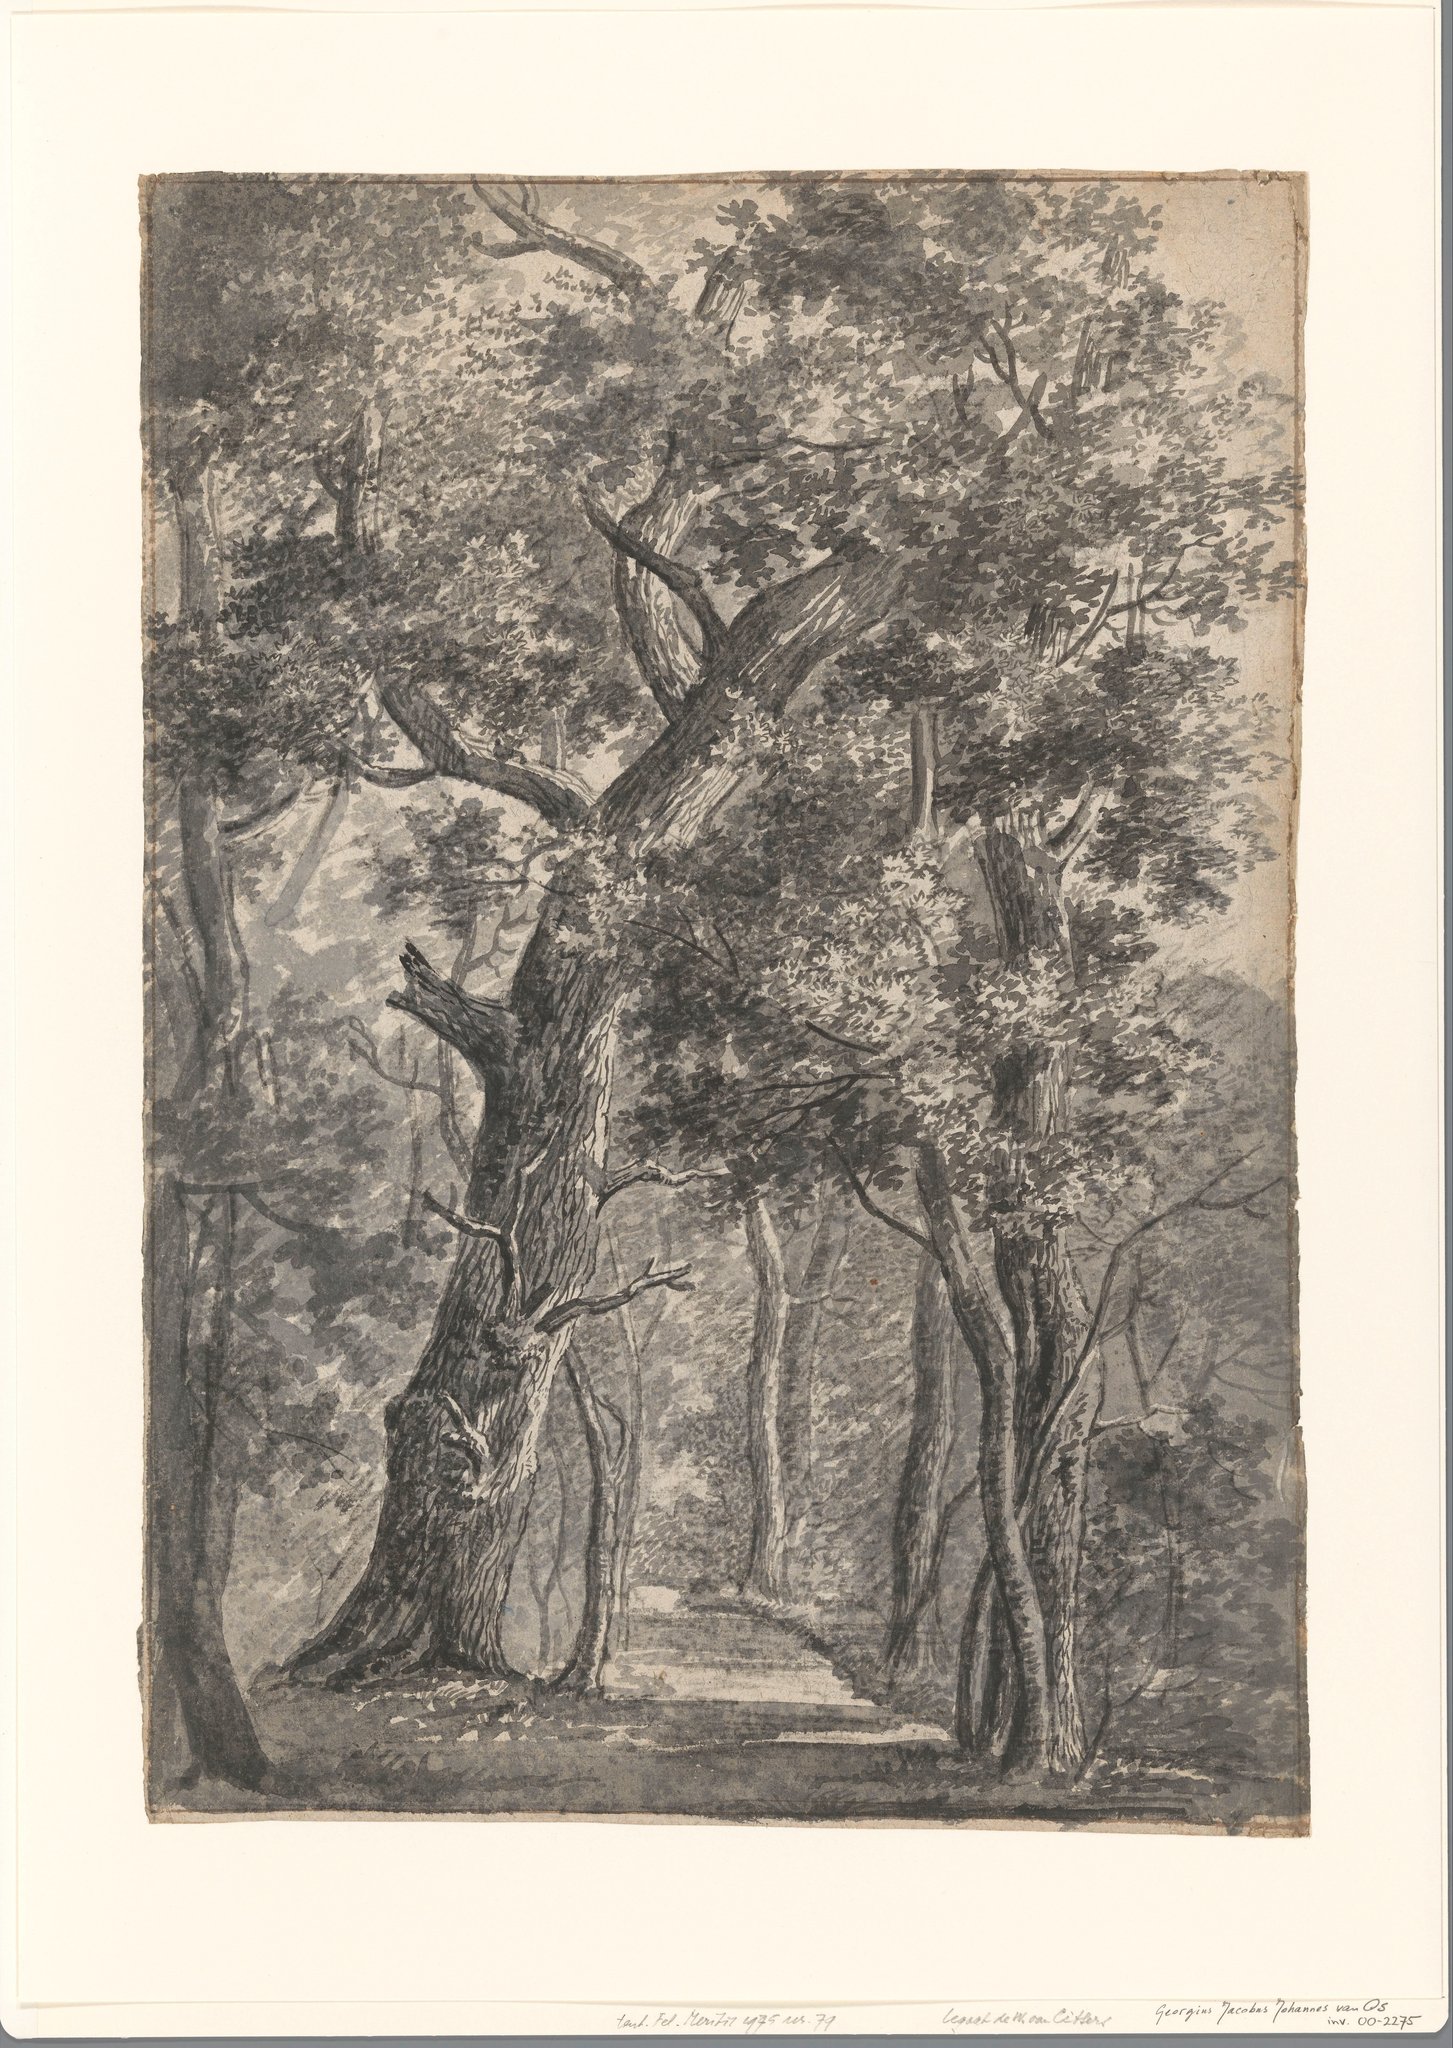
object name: drawing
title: Gezicht in bos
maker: georgius jacobus johannes van os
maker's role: draughtsman, painter, print maker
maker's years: 1782-1861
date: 1792-1861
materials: chalk, paper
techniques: brush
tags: trees, forest, wood